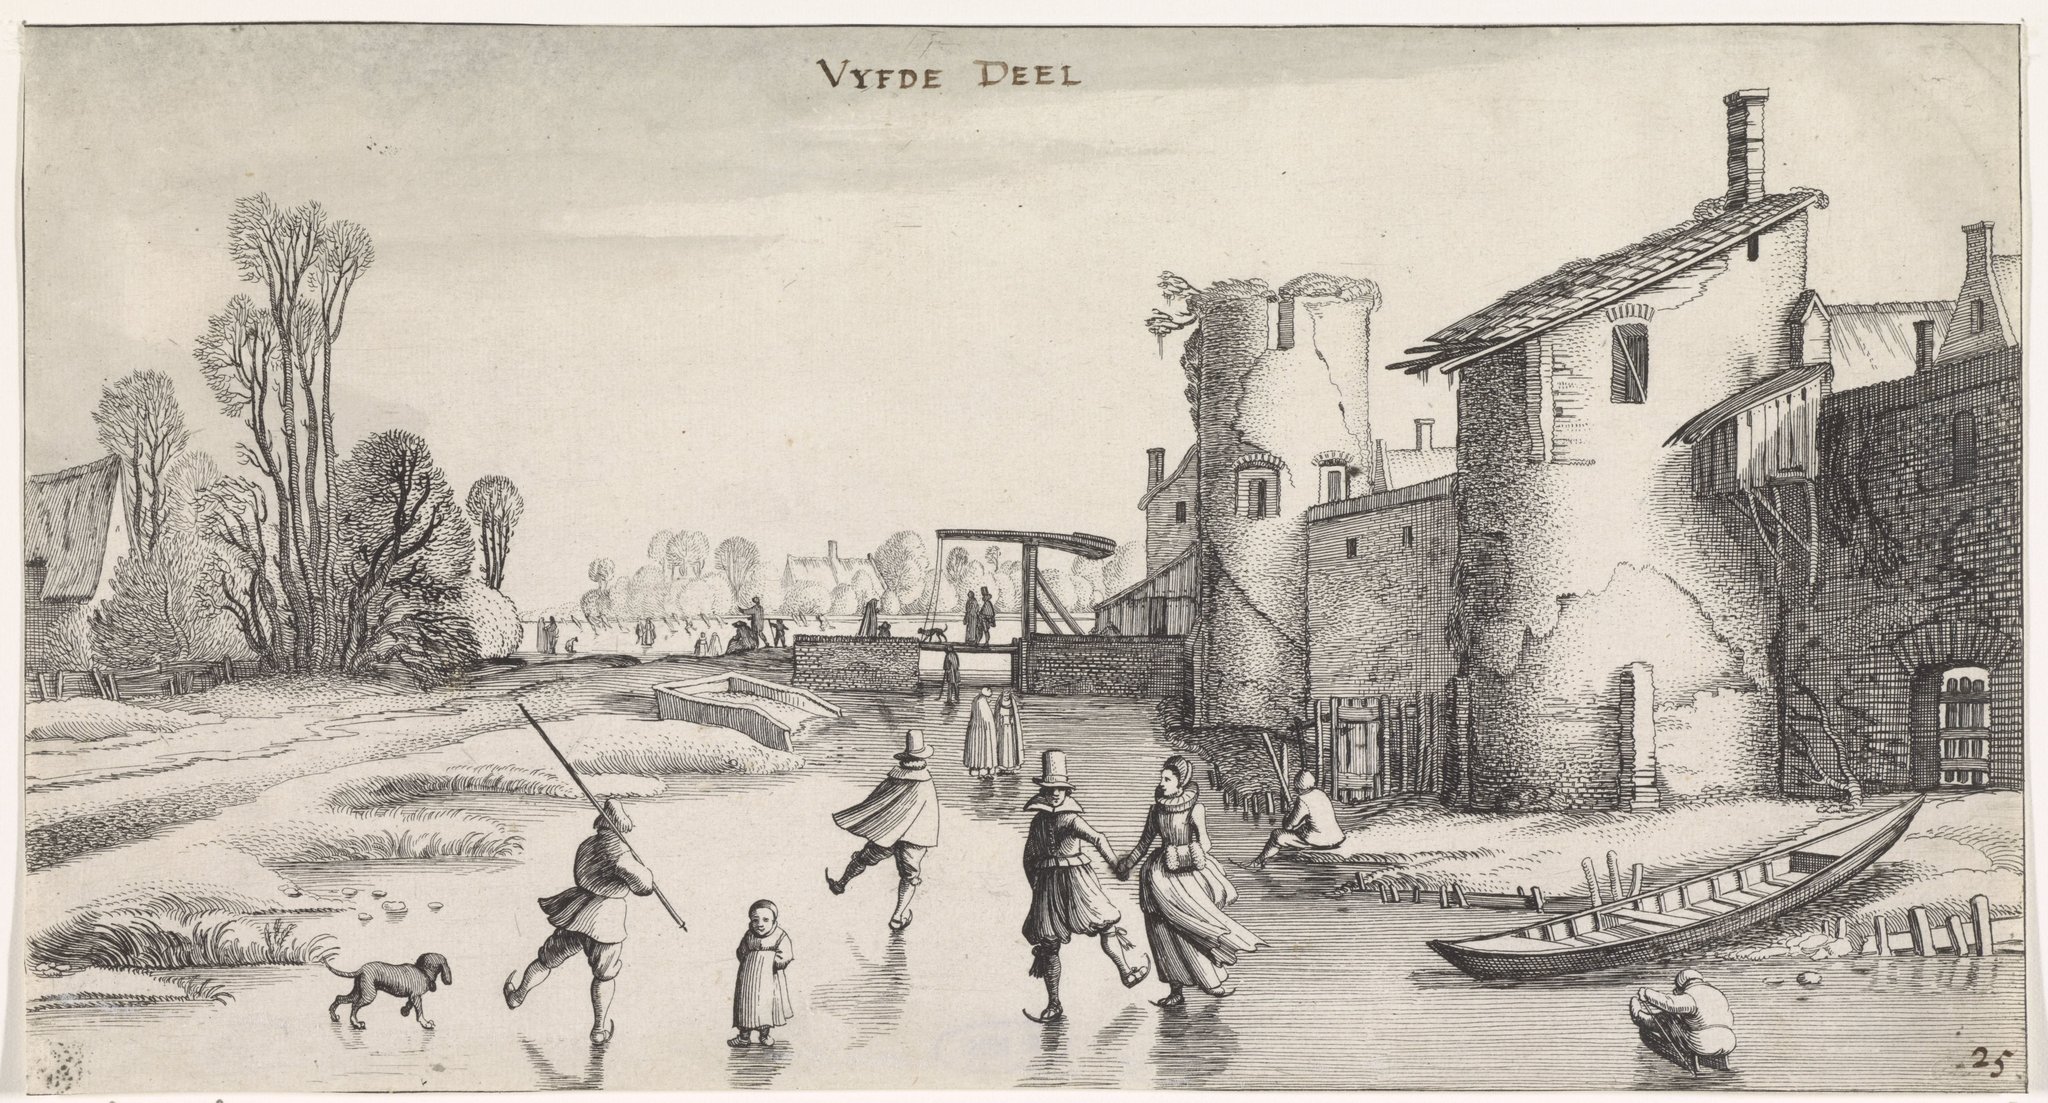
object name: print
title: Winterlandschap met schaatsers bij een stadsmuur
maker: jan van de velde (ii)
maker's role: draughtsman, painter, print maker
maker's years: 1593-1641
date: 1639-1641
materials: ink, paper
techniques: brush, etching, pen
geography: northern netherlands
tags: bascule bridge, skates (winter sports), city-walls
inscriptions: number: ‘25’, collector's mark: Lugt 1120, inscription: ‘Vyfde Deel’, collector's mark: Lugt 2228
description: Winterlandschap met schaatsers bij een stadsmuur. In het midden een ophaalbrug over de gracht. 25ste prent van een serie met 36 prenten van landschappen, verdeeld over zes delen.